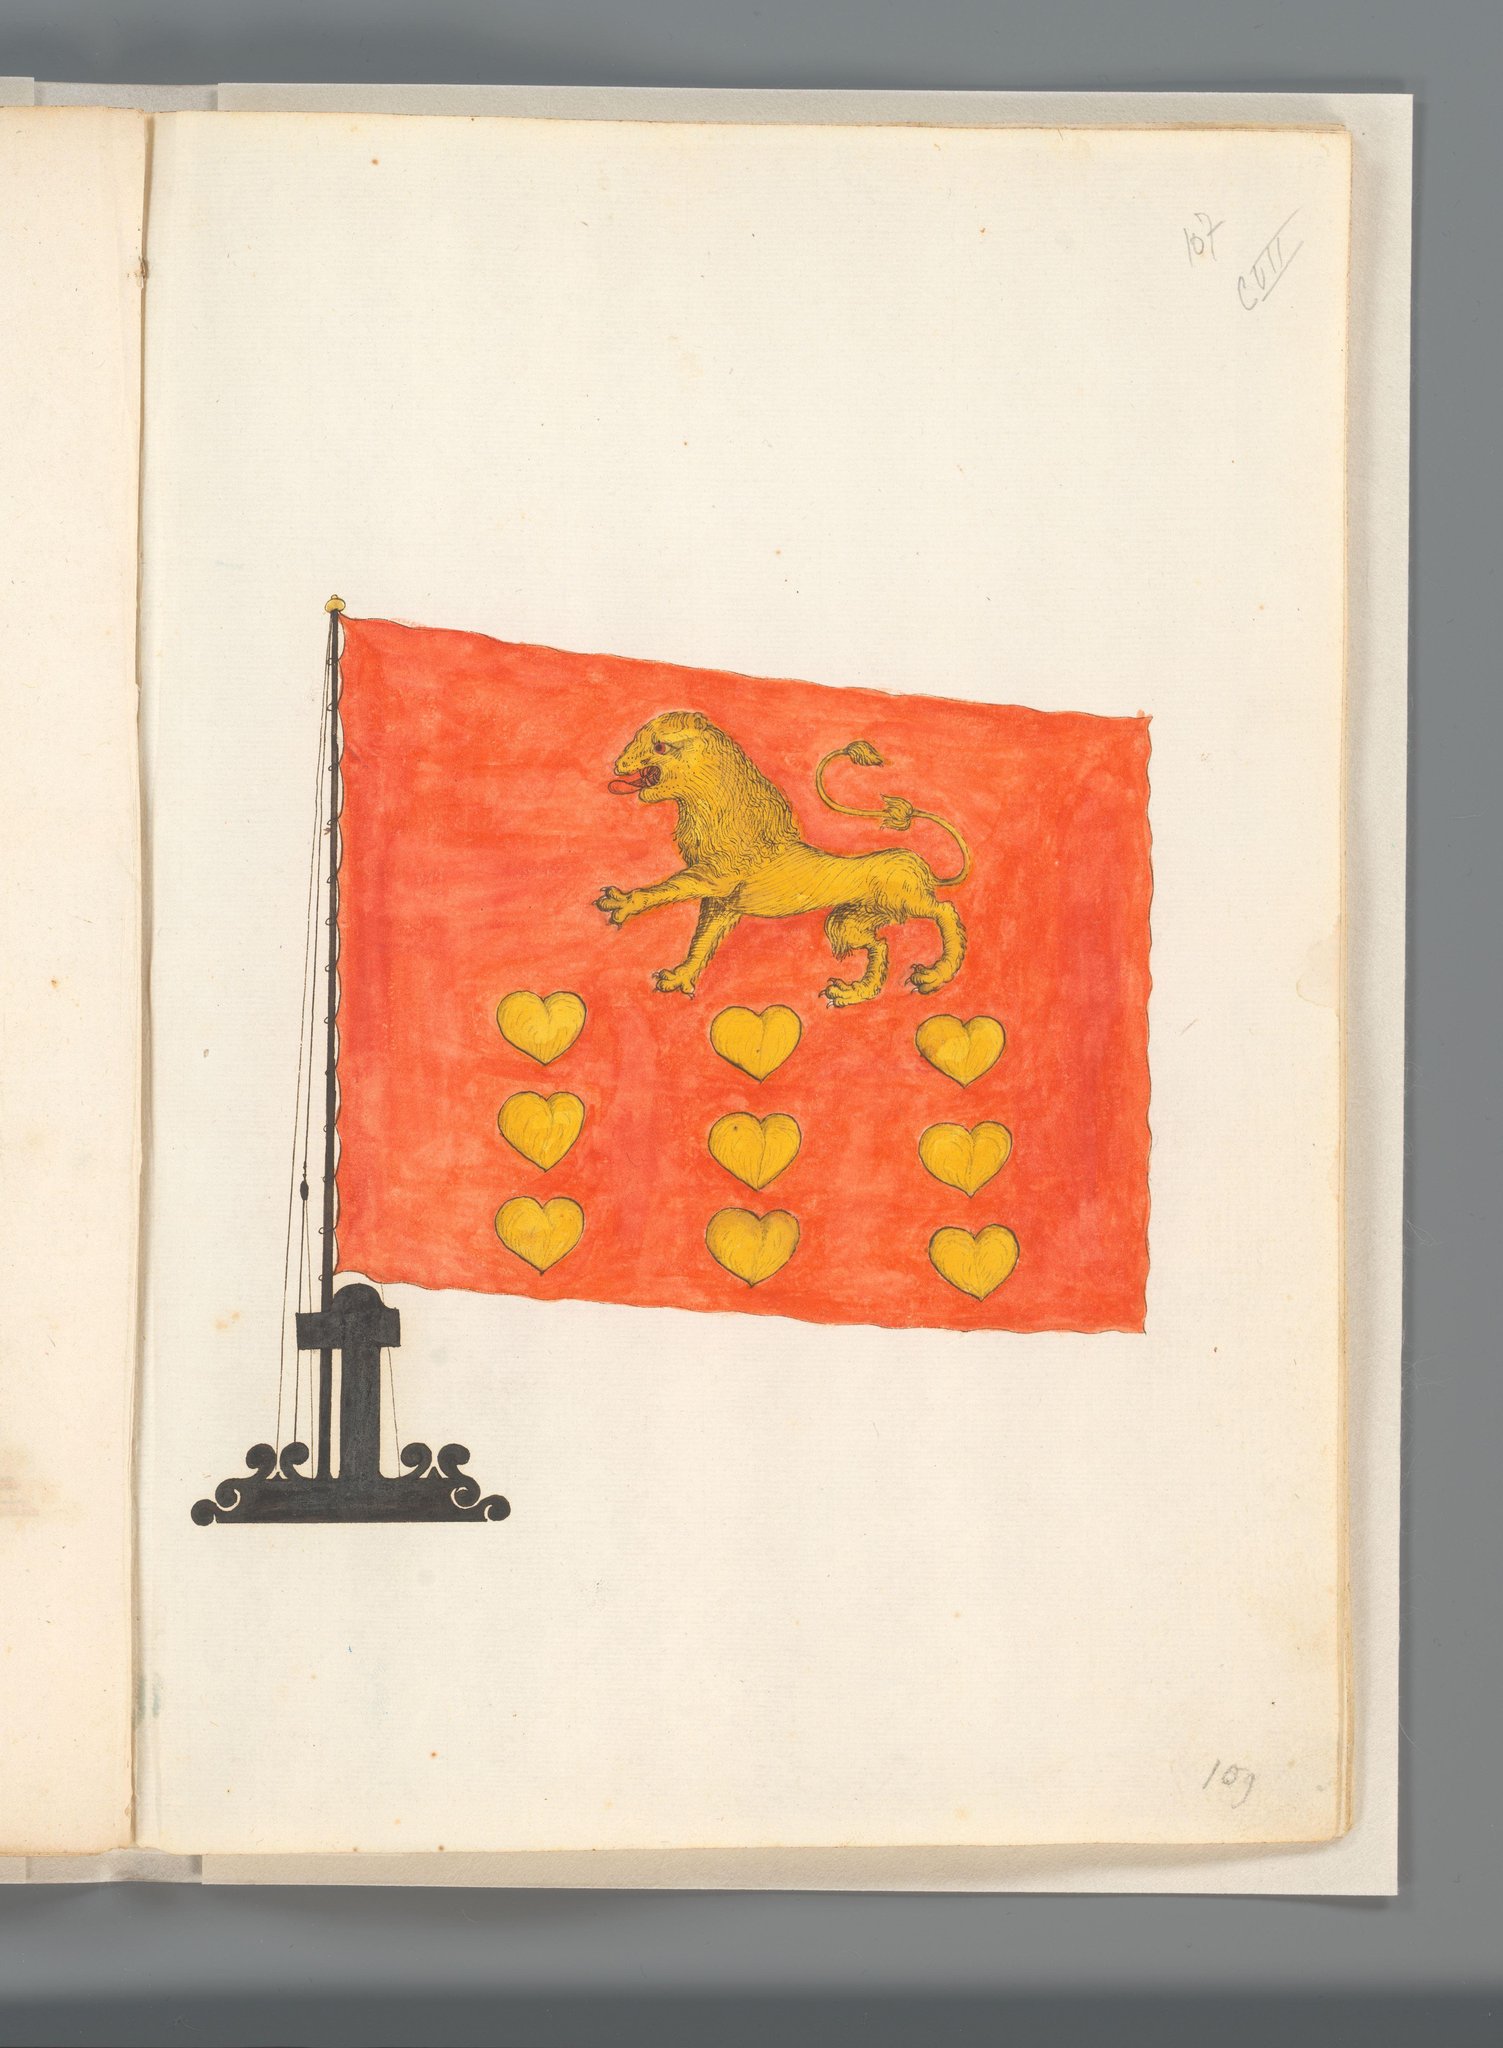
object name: drawing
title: Vlag van Götaland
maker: Anonymous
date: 1667-1670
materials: ink, paper, watercolor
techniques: brush, pen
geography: france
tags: flag, colours (as symbol of the state, etc.)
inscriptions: number: ‘107 / CVII / 109’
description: Vlag van (het koninkrijk) Götaland, het historische zuidelijke landsdeel van Zweden. Gaande leeuw op een rood veld boven negen gouden harten. Vlag op vlaggensteng en mastvoet. Afgebeeld op folio 55r. Onderdeel van een vlaggenboek met vlaggen uit Europa, Noord-Afrika, Nabije en Verre Oosten.